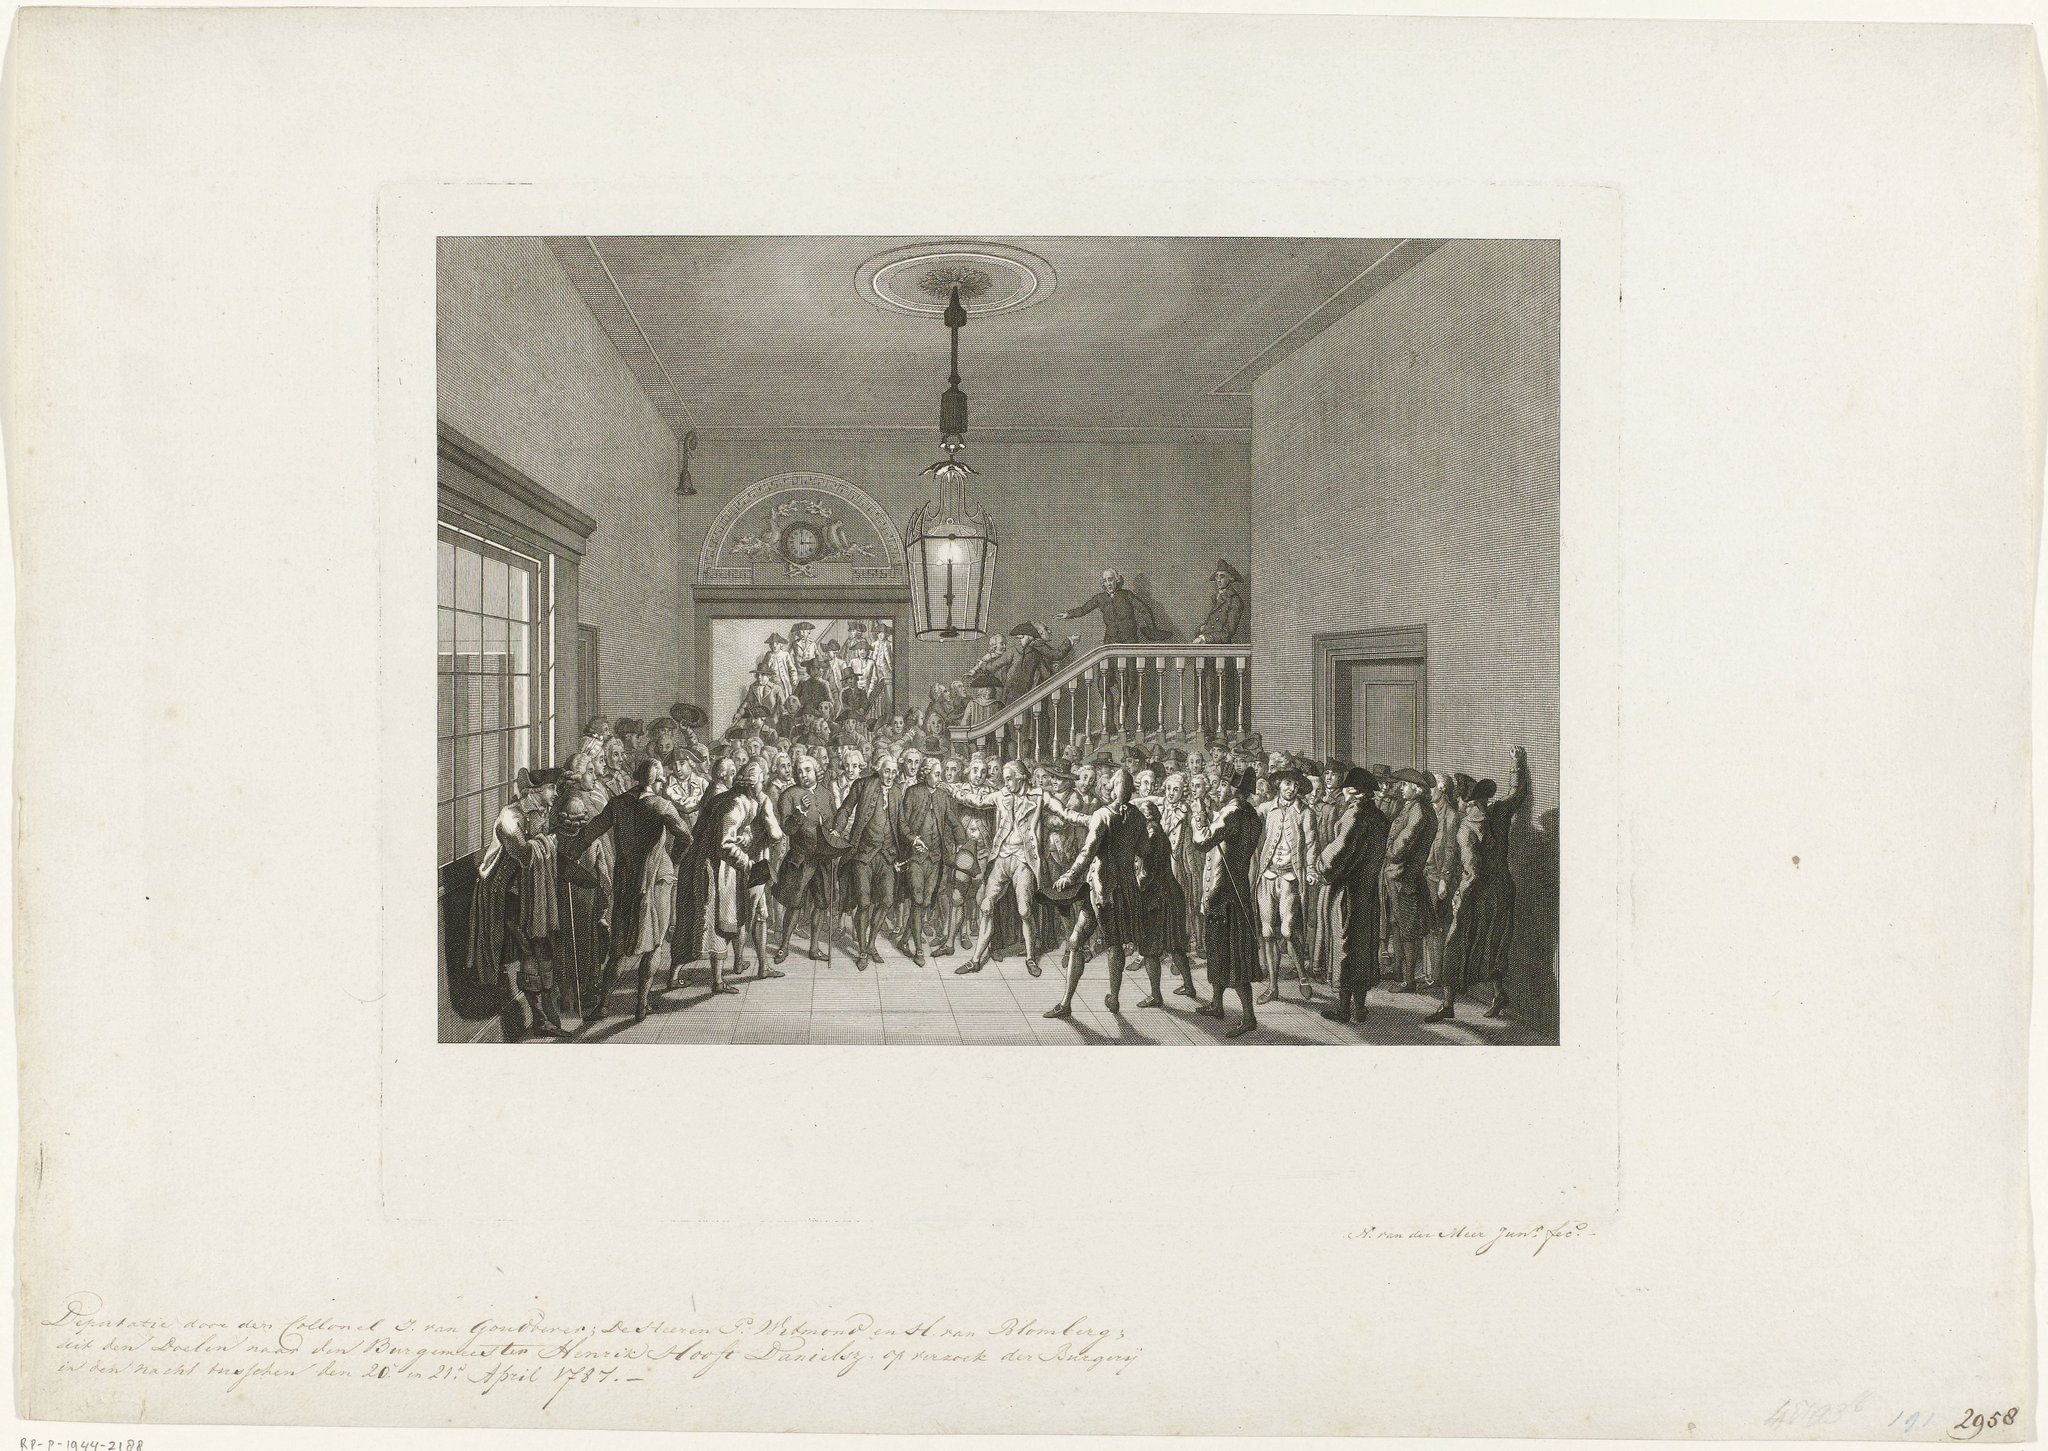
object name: print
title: Deputatie uit de Doelen naar burgemeester Hooft, 1787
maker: noach van der meer (ii)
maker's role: draughtsman, print maker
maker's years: 1741-1822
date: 1787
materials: paper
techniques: engraving, etching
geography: northern netherlands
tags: amsterdam, mayor, hendrik danielsz. hooft, revolutionary council, patriots (1780-1795)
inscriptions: collector's mark: Lugt 2228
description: Een deputatie bestaande uit kolonel Isaak van Goudoever, Pieter Witmond en Hendrik van Blomberg vanuit de Garnalendoelen naar burgemeester Hendrik Danielsz. Hooft met het verzoek namens de burgerij van Amsterdam om de remotie van negen raadsleden, in de nacht van 20 op 21 april 1787.